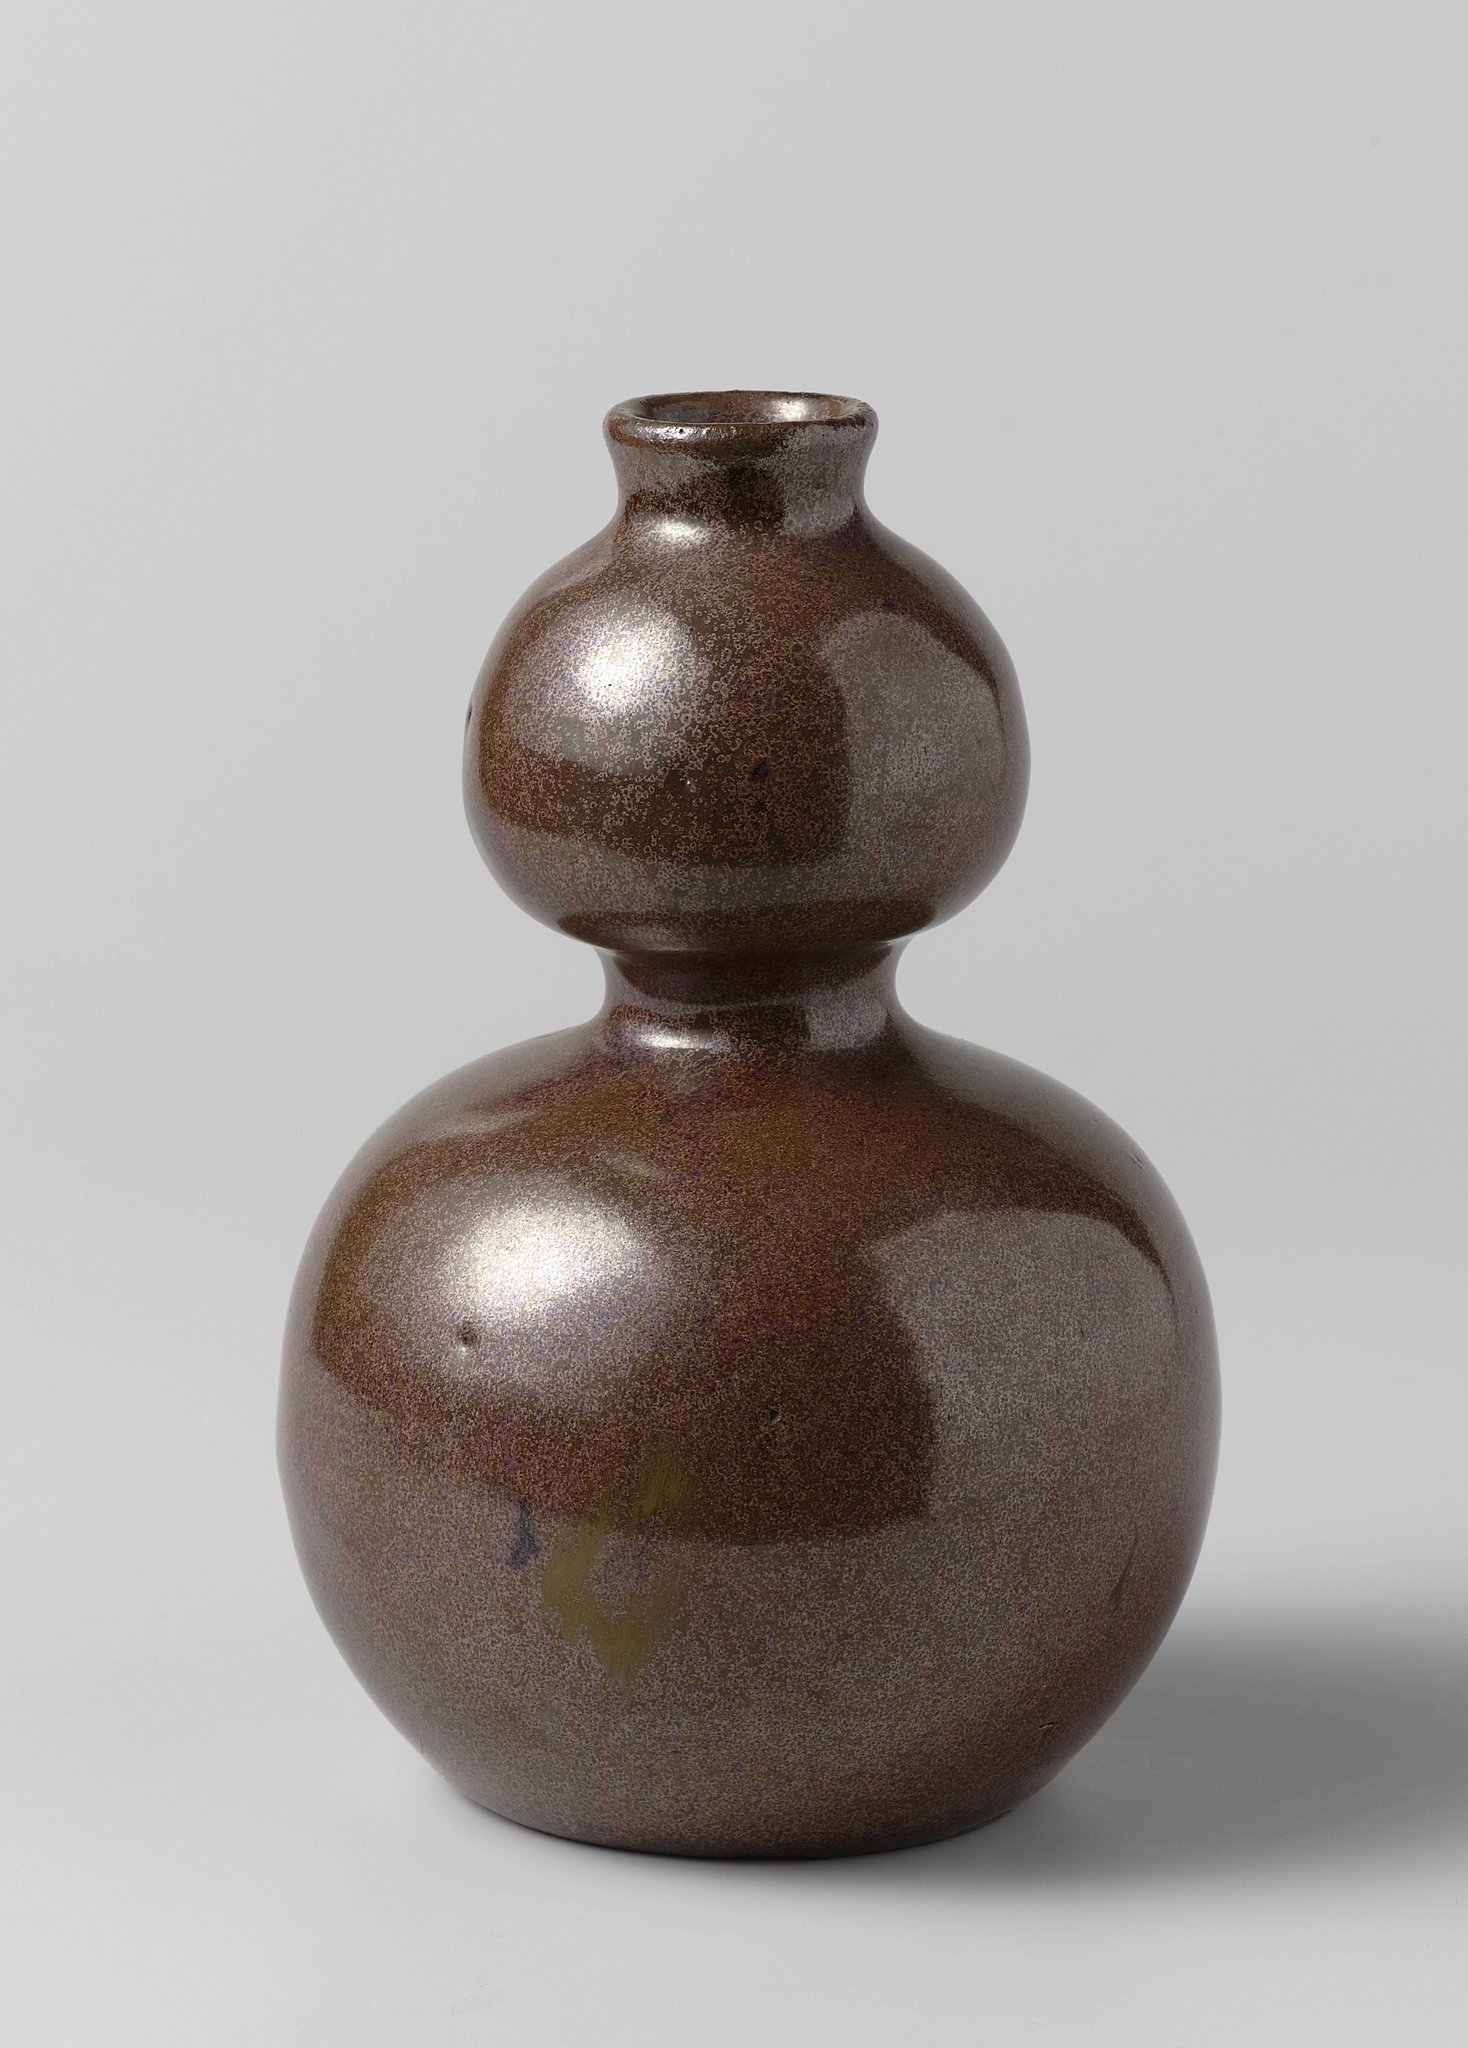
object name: vase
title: Gourd-shaped vase with a 'tea-dust' glaze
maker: Anonymous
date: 1800-1899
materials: glaze, stoneware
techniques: firing, turning, vitrification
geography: japan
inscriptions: label: ‘W842’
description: Kalebasvormige vaas van steengoed met een korte, iets spreidende nek, bedekt met een bronskleurig glazuur (tea-dust). De onderzijde is ongeglazuurd. Oud label op de onderzijde met 'W842'.